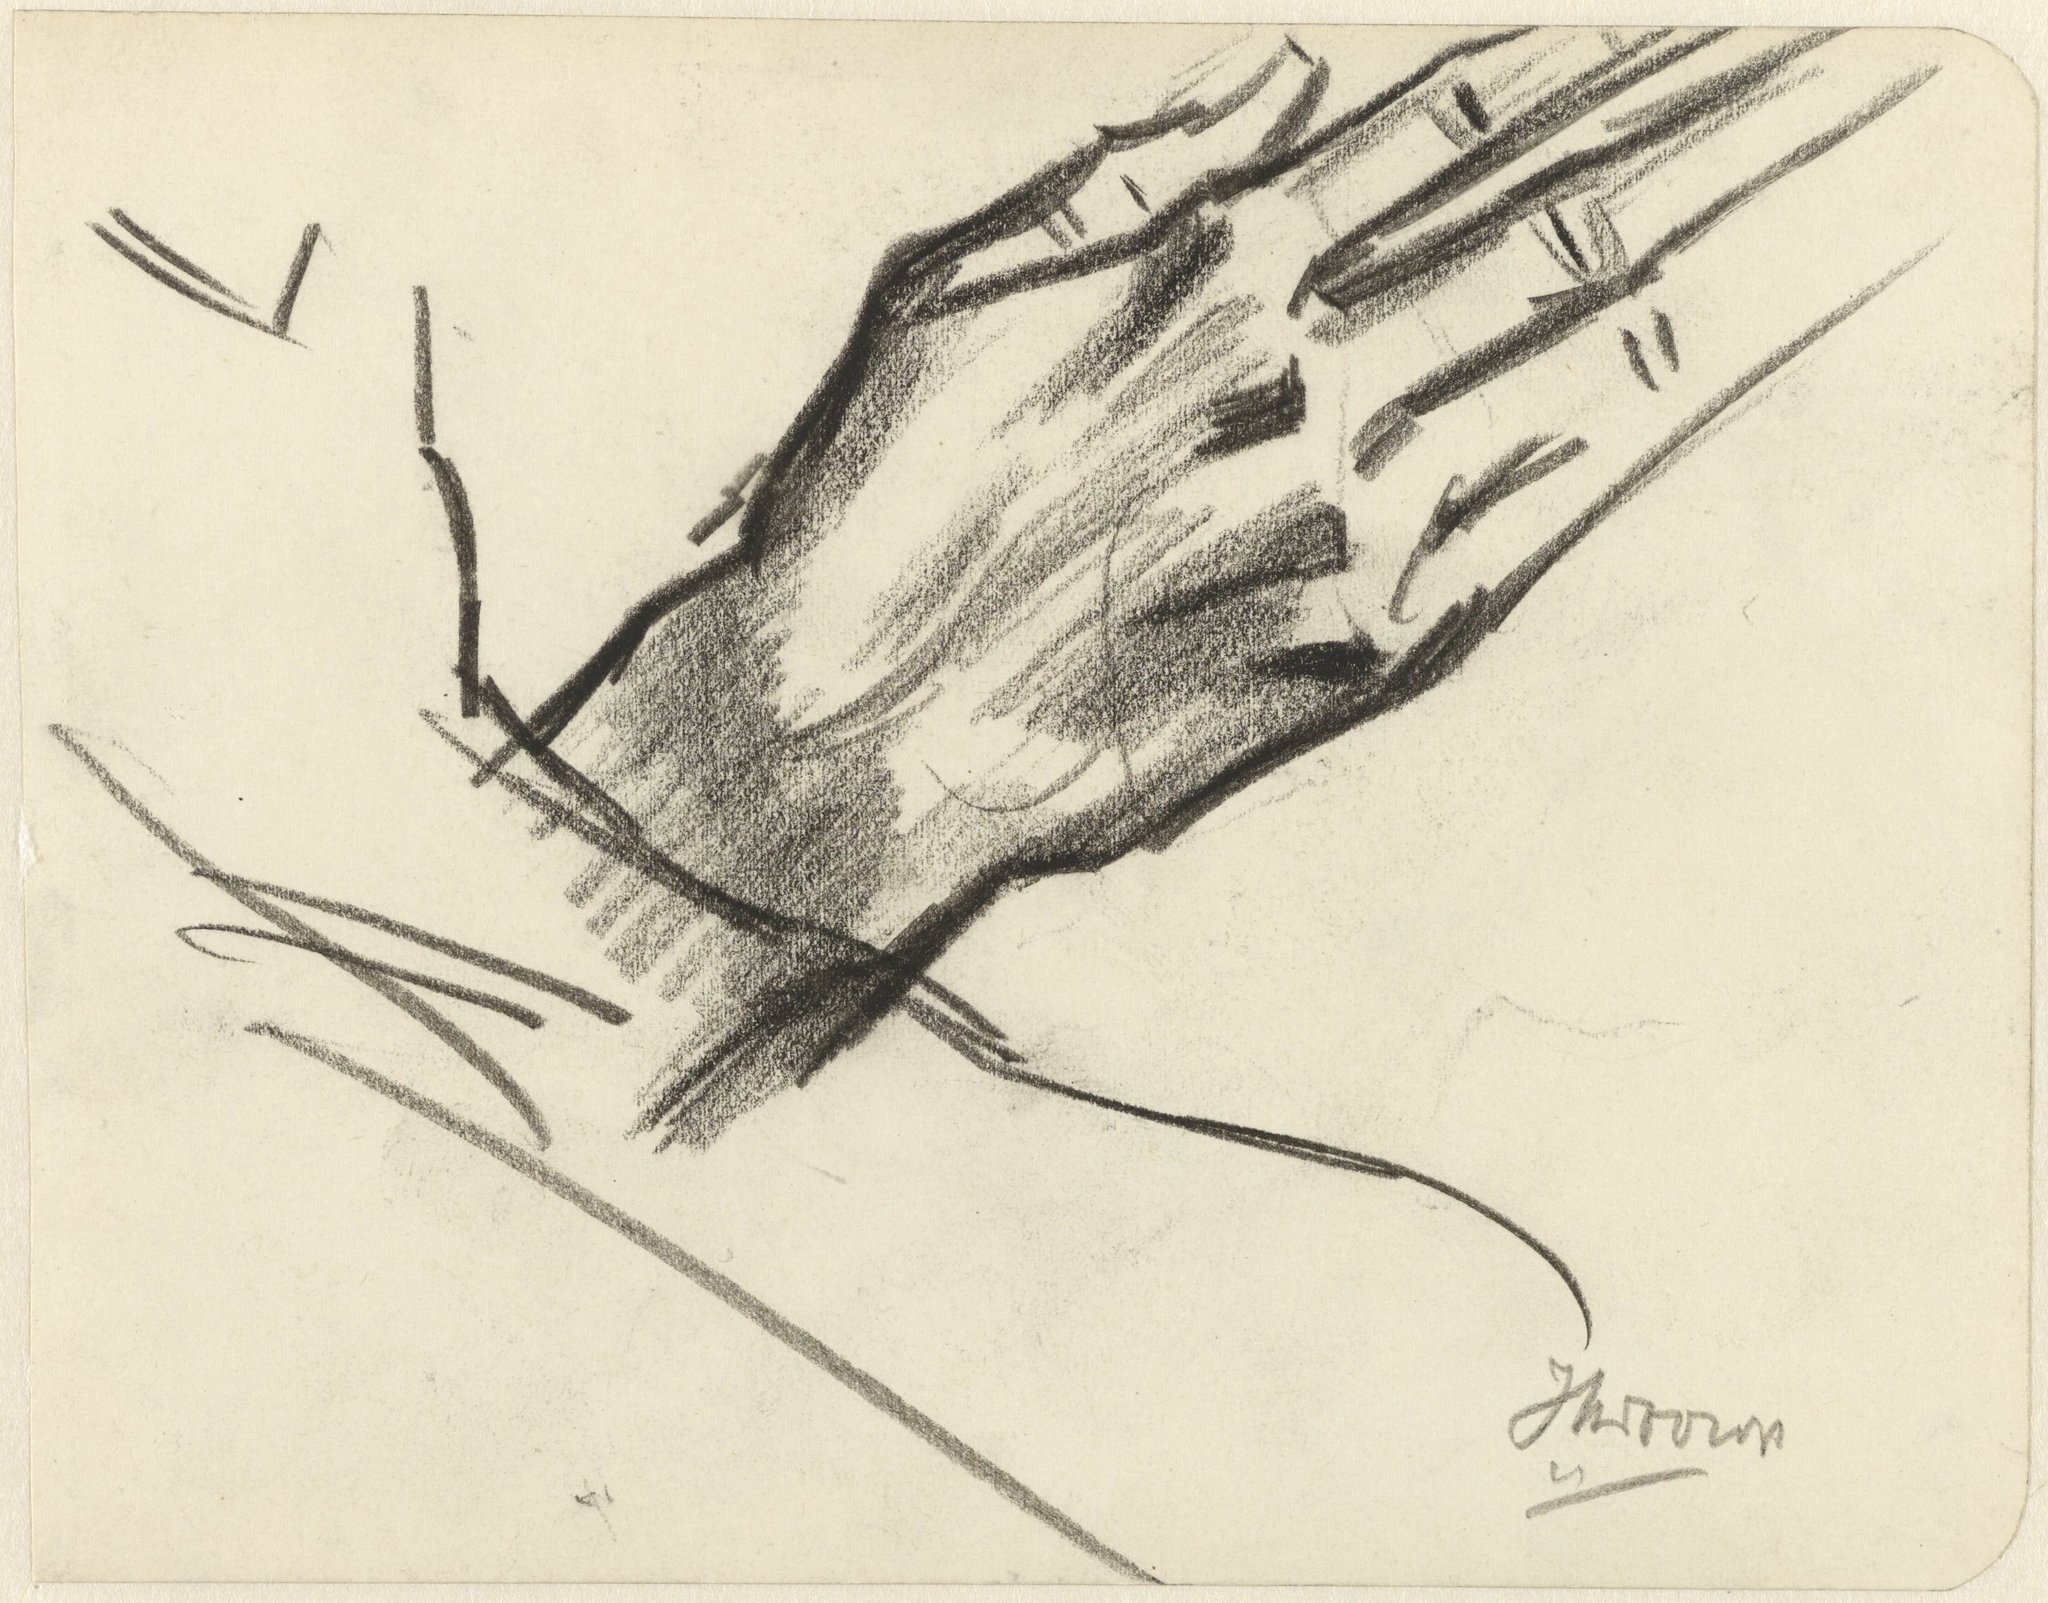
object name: drawing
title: Studie van een hand en een onderarm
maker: jan toorop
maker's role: draughtsman, painter, print maker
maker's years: 1858-1928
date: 1868-1928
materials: chalk, paper